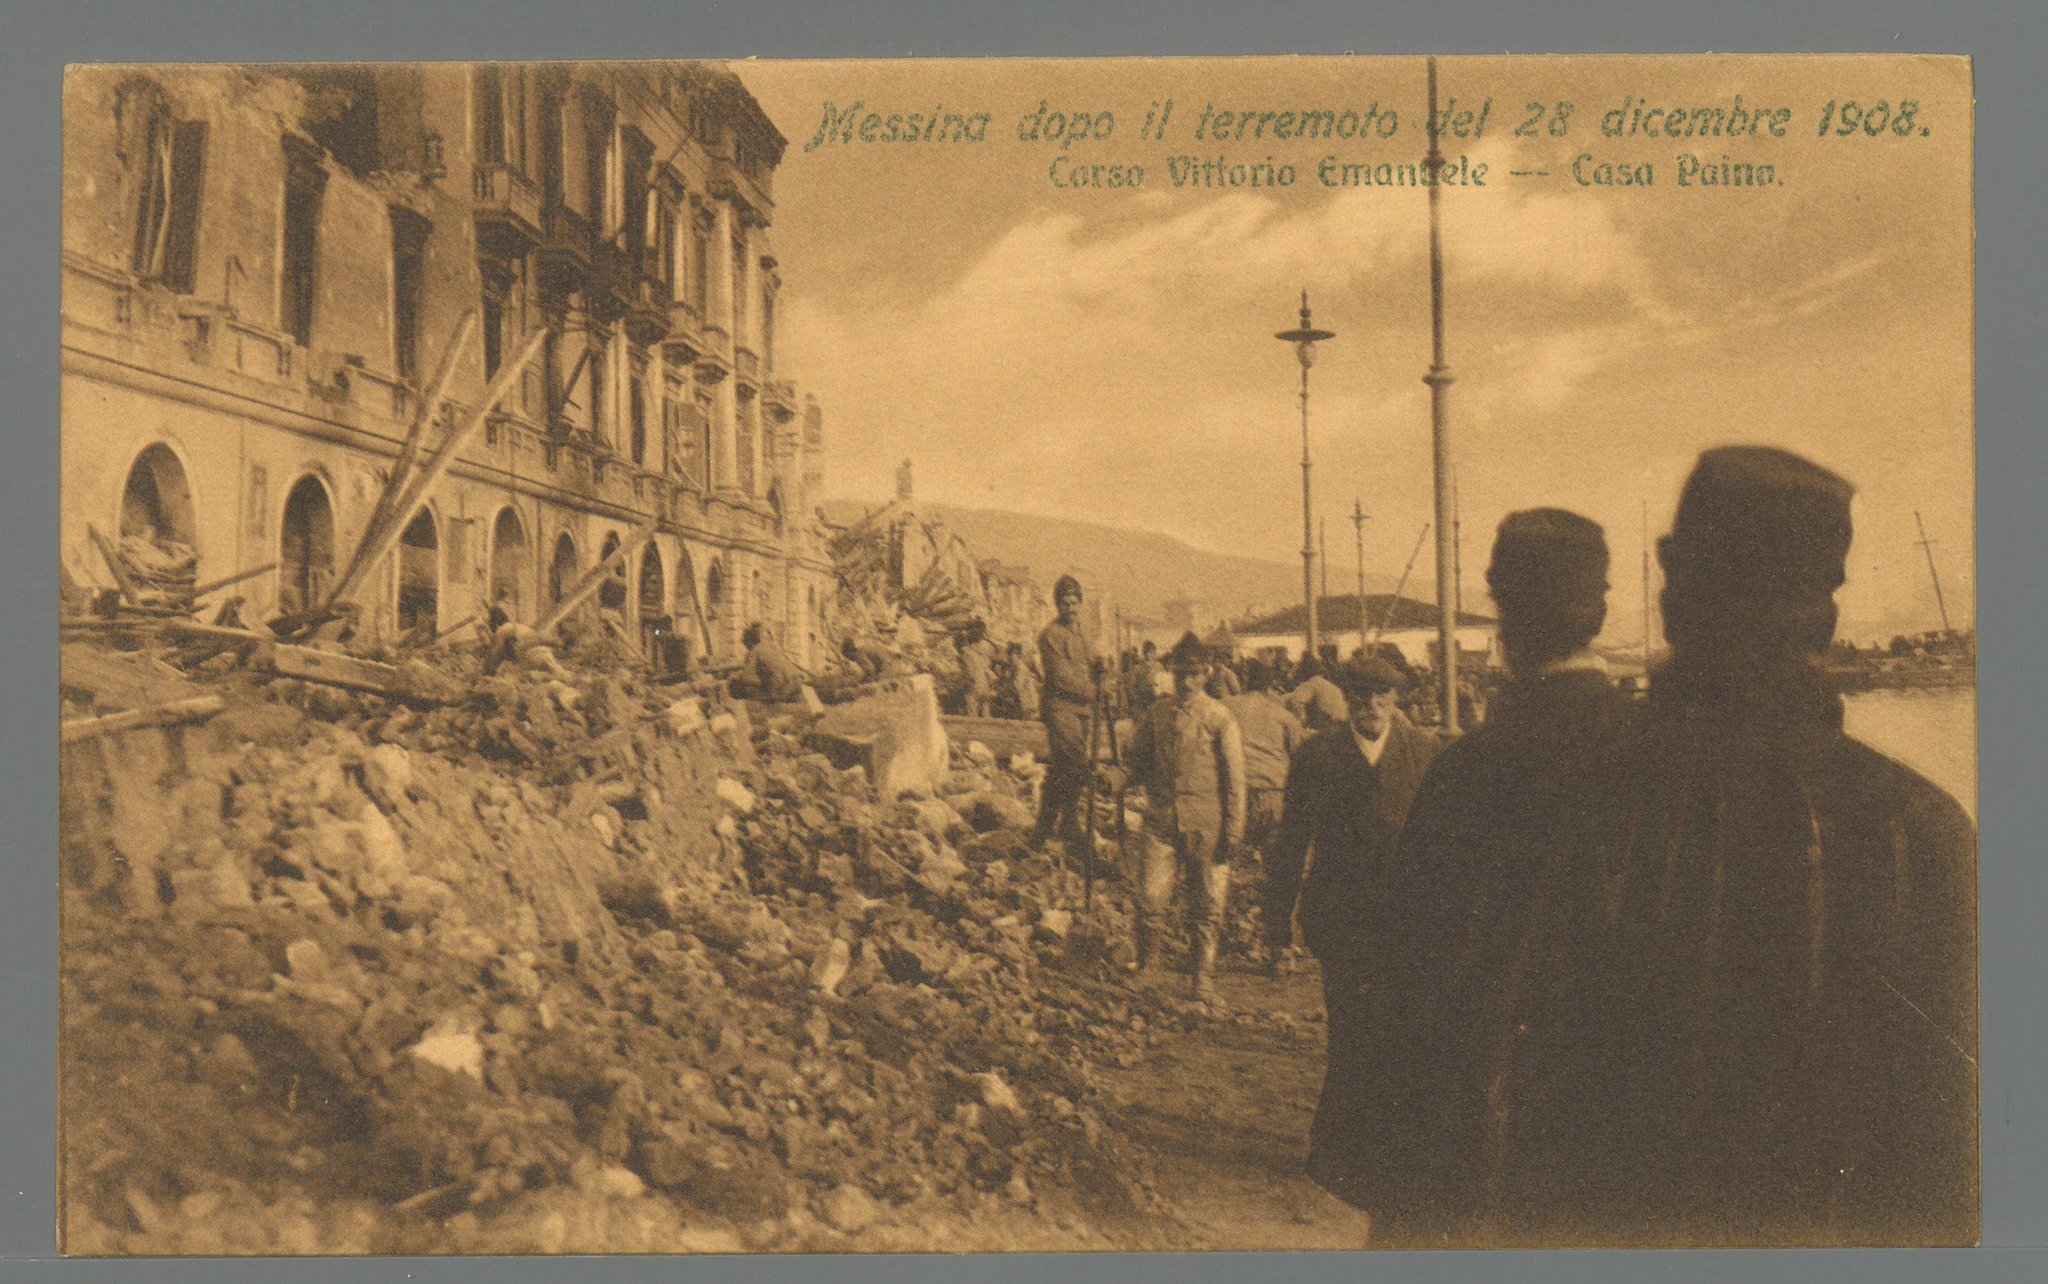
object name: ansichtkaart, prentbriefkaart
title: Corso Vittorio Emanuele. Casa Paina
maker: Anonymous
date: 1908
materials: cardboard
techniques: photograph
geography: messina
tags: consequences of an earthquake, collapsing building, city-view, and landscape with man-made constructions (+ city(-scape) with figures, staffage)